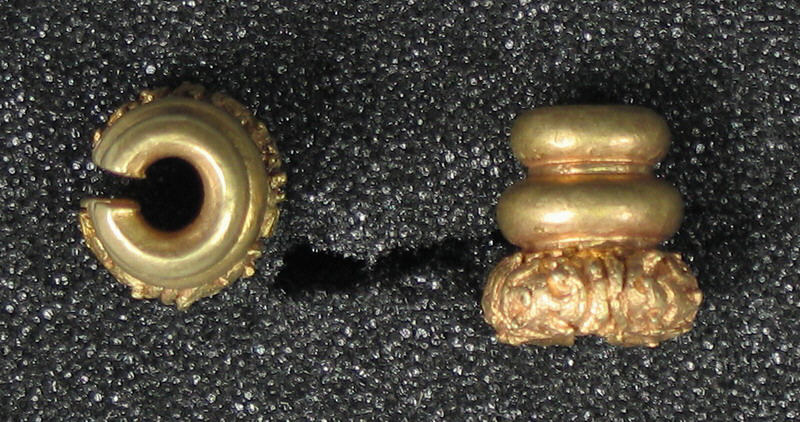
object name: pair of earring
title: Pair of Earrings with Three Hoops, Incised Floral Design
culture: indonesian, central java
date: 701-1200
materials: gold